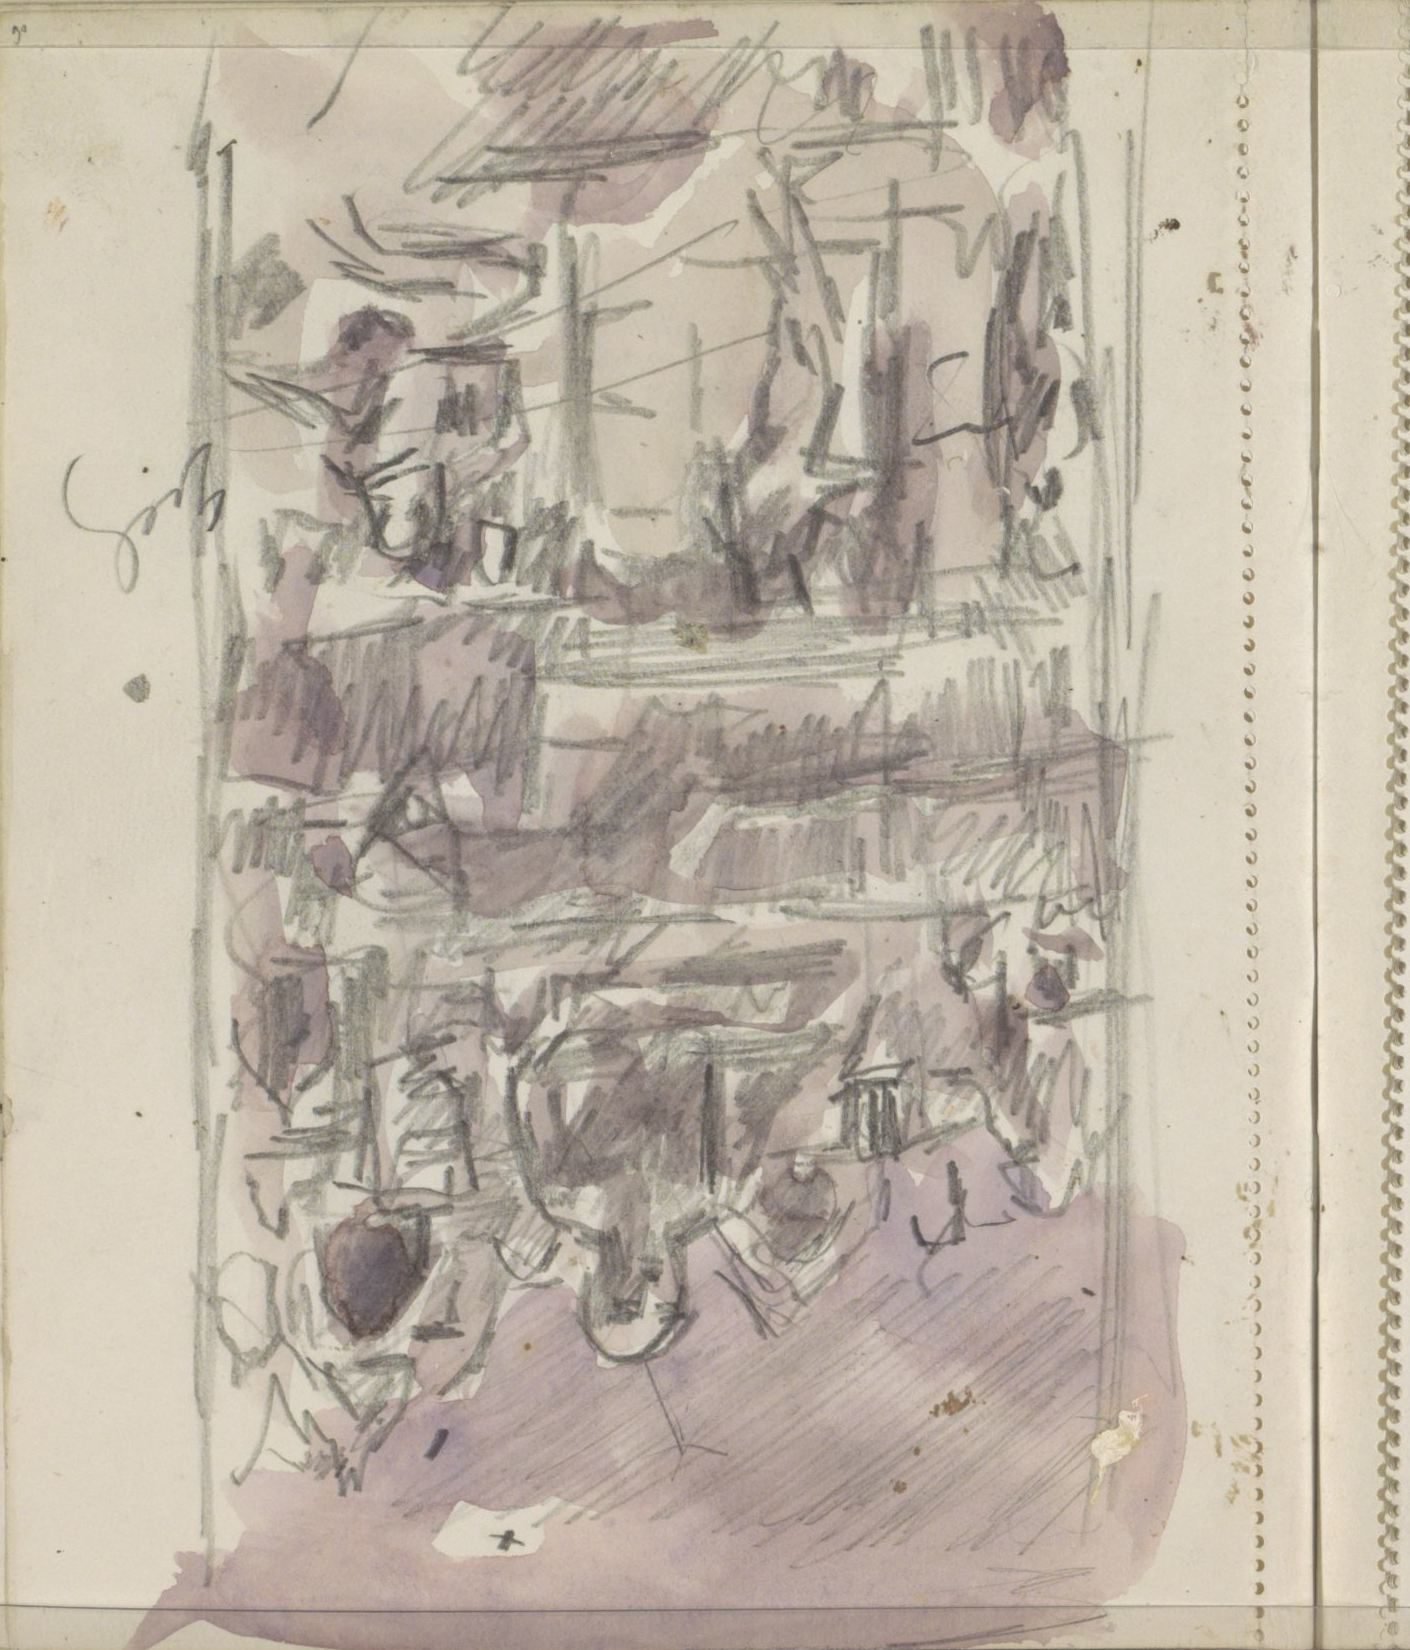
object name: sketchbook leaf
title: Borobudur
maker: marius bauer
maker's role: draughtsman, print maker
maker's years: 1867-1932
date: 1925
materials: paper, pencil, watercolor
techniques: brush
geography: java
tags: places and objects of worship ~ hinduism, buddhism, jainism, statues, paintings, etc. ~ objects of worship (hinduism, buddhism, jainism)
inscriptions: kleurnotitie, handgeschreven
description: Pagina 90 uit een schetsboek met 67 bladen.